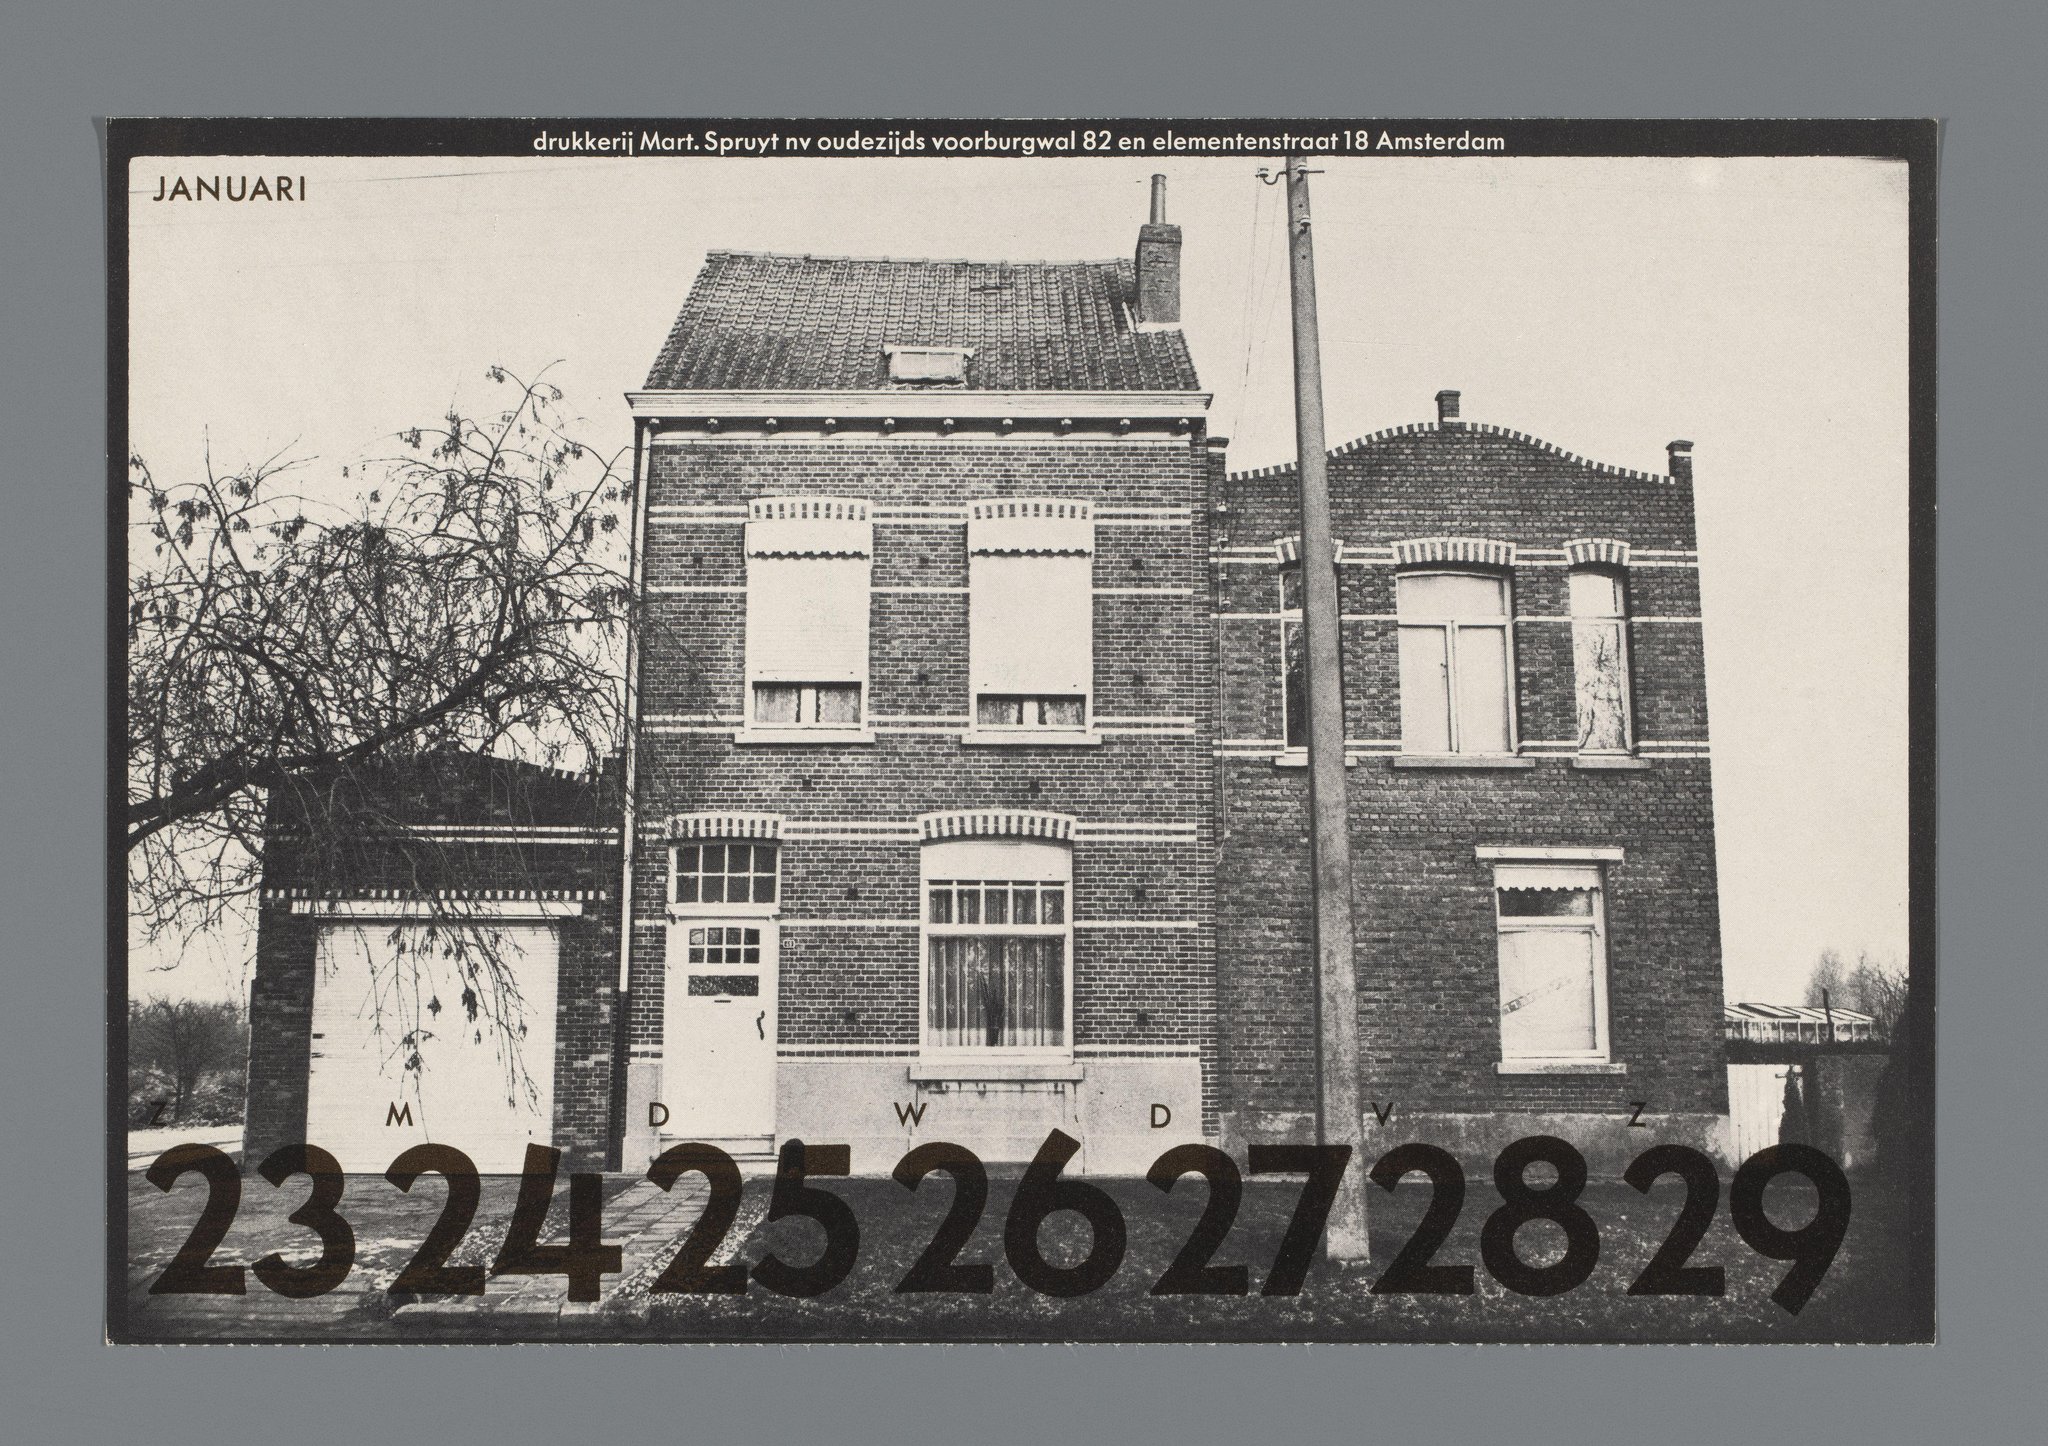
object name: photograph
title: België. Huizen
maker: Anonymous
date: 1900-1950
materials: paper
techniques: offset printed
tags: belgium